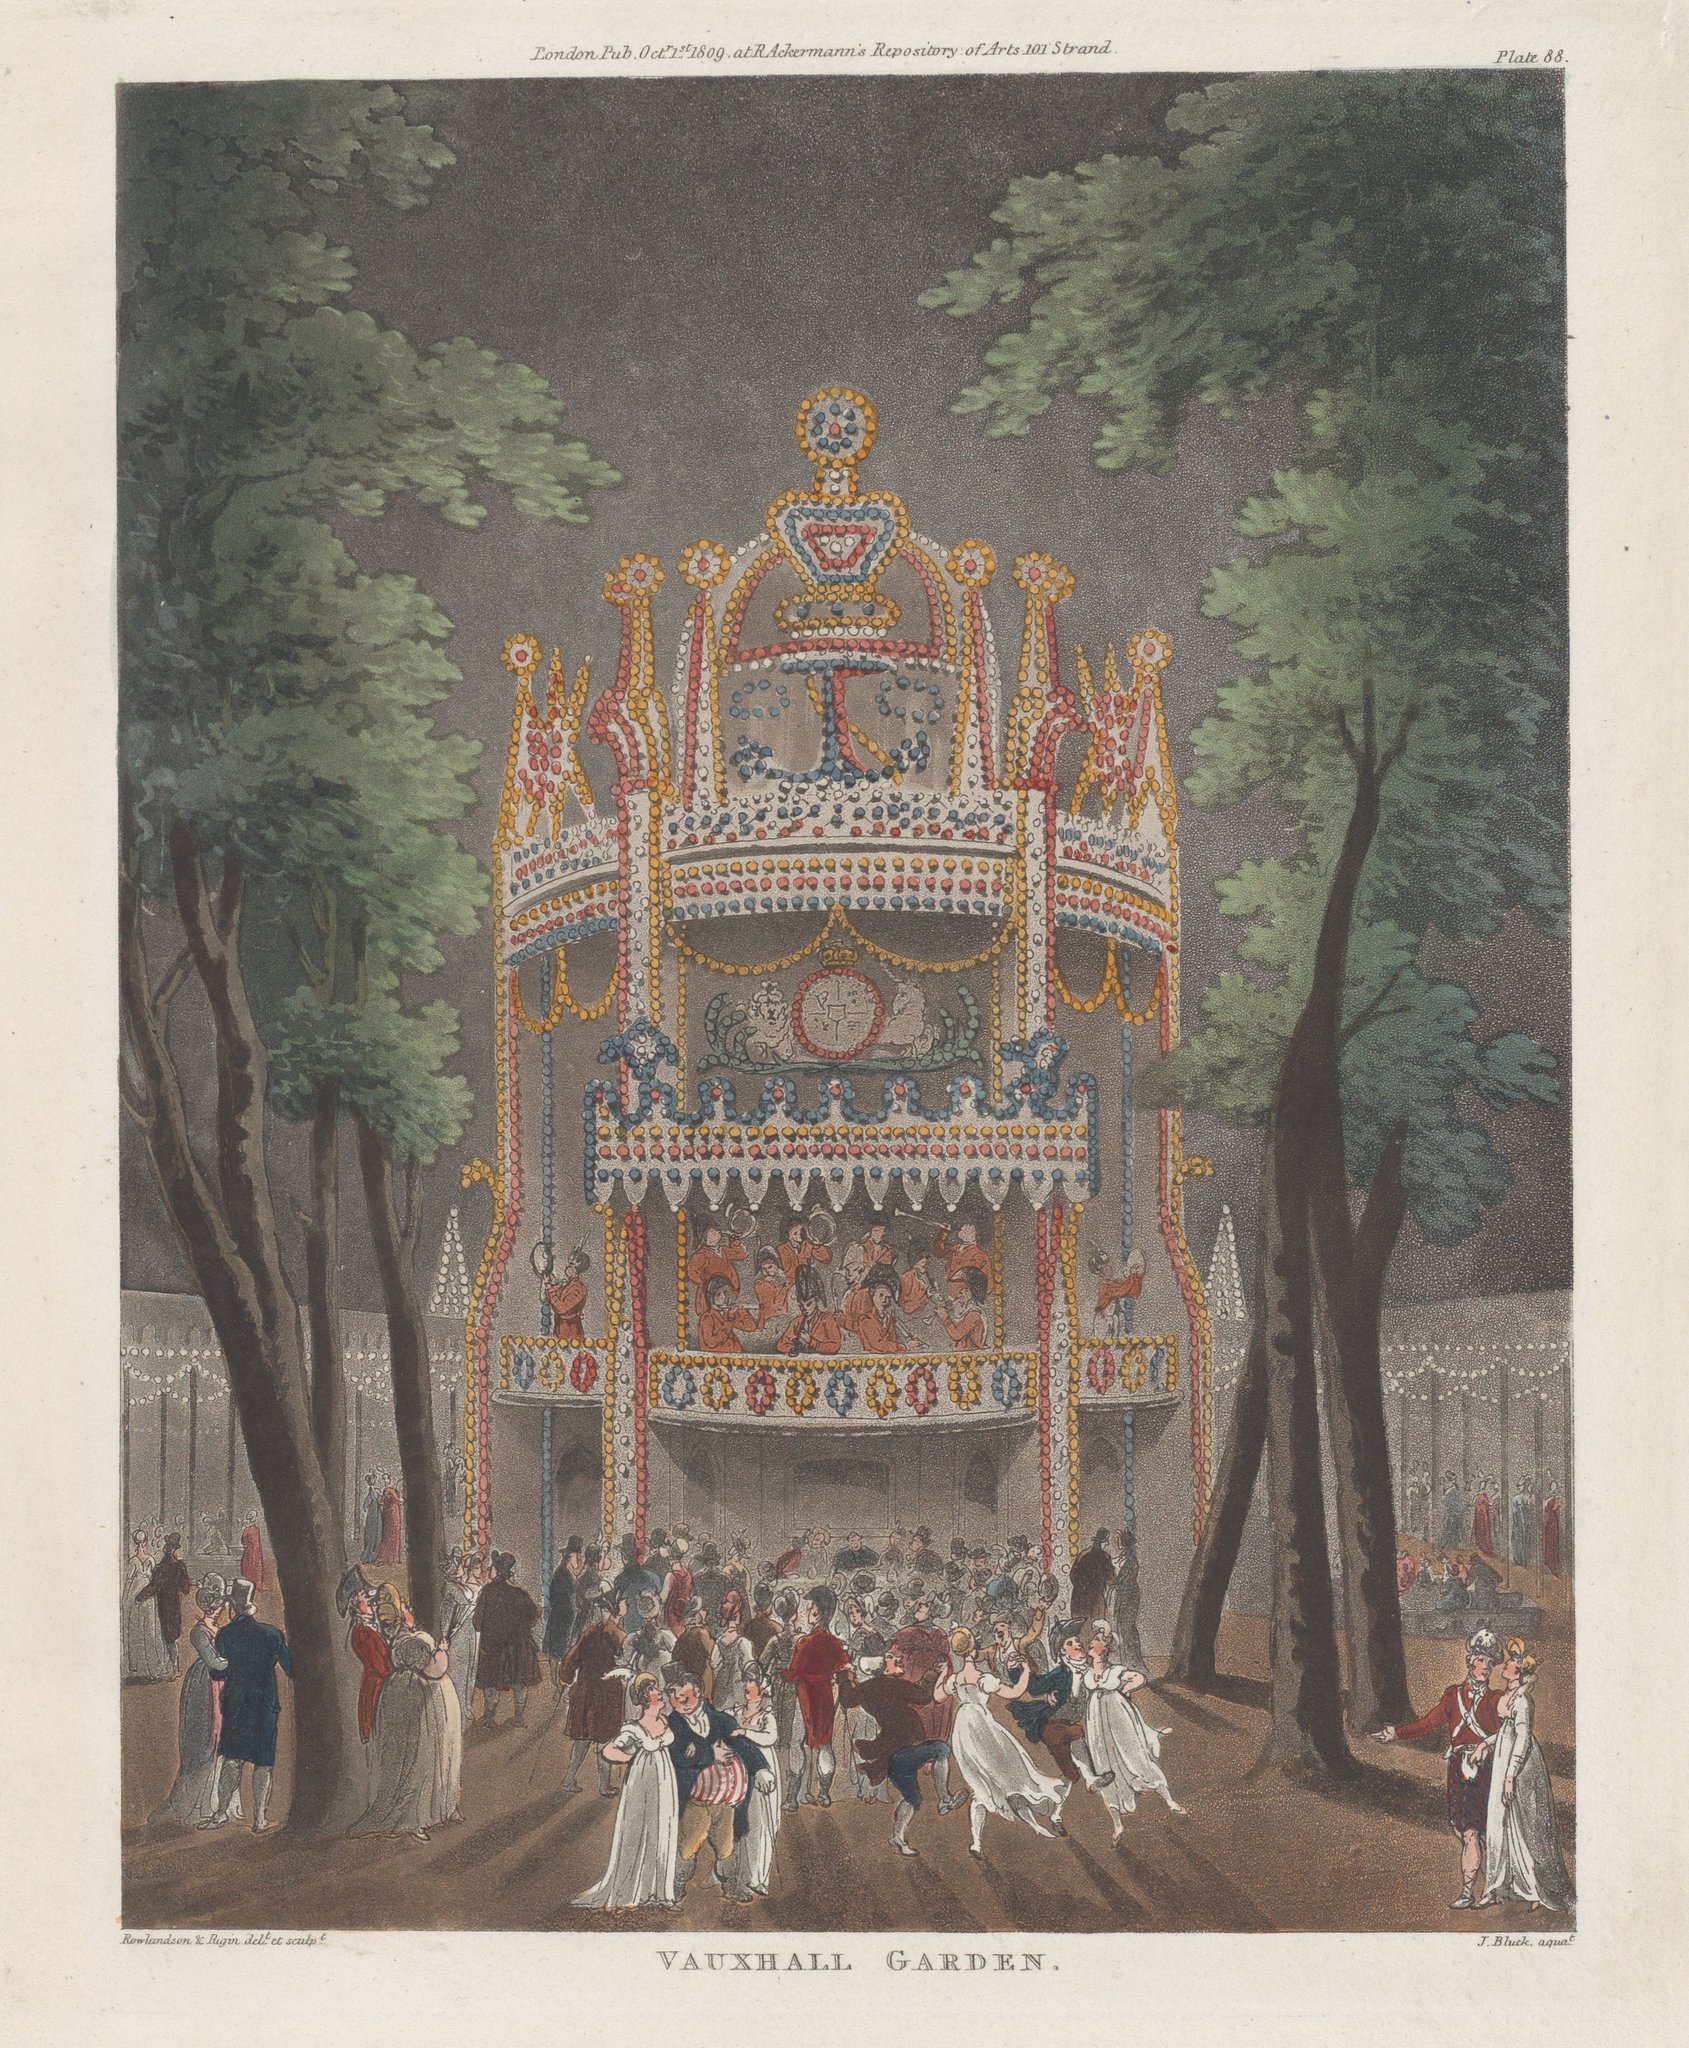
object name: print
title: Vauxhall Garden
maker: thomas rowlandson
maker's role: artist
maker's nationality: british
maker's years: 1757-1827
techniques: aquatint, etching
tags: leisure,men,women,dancing,musicians